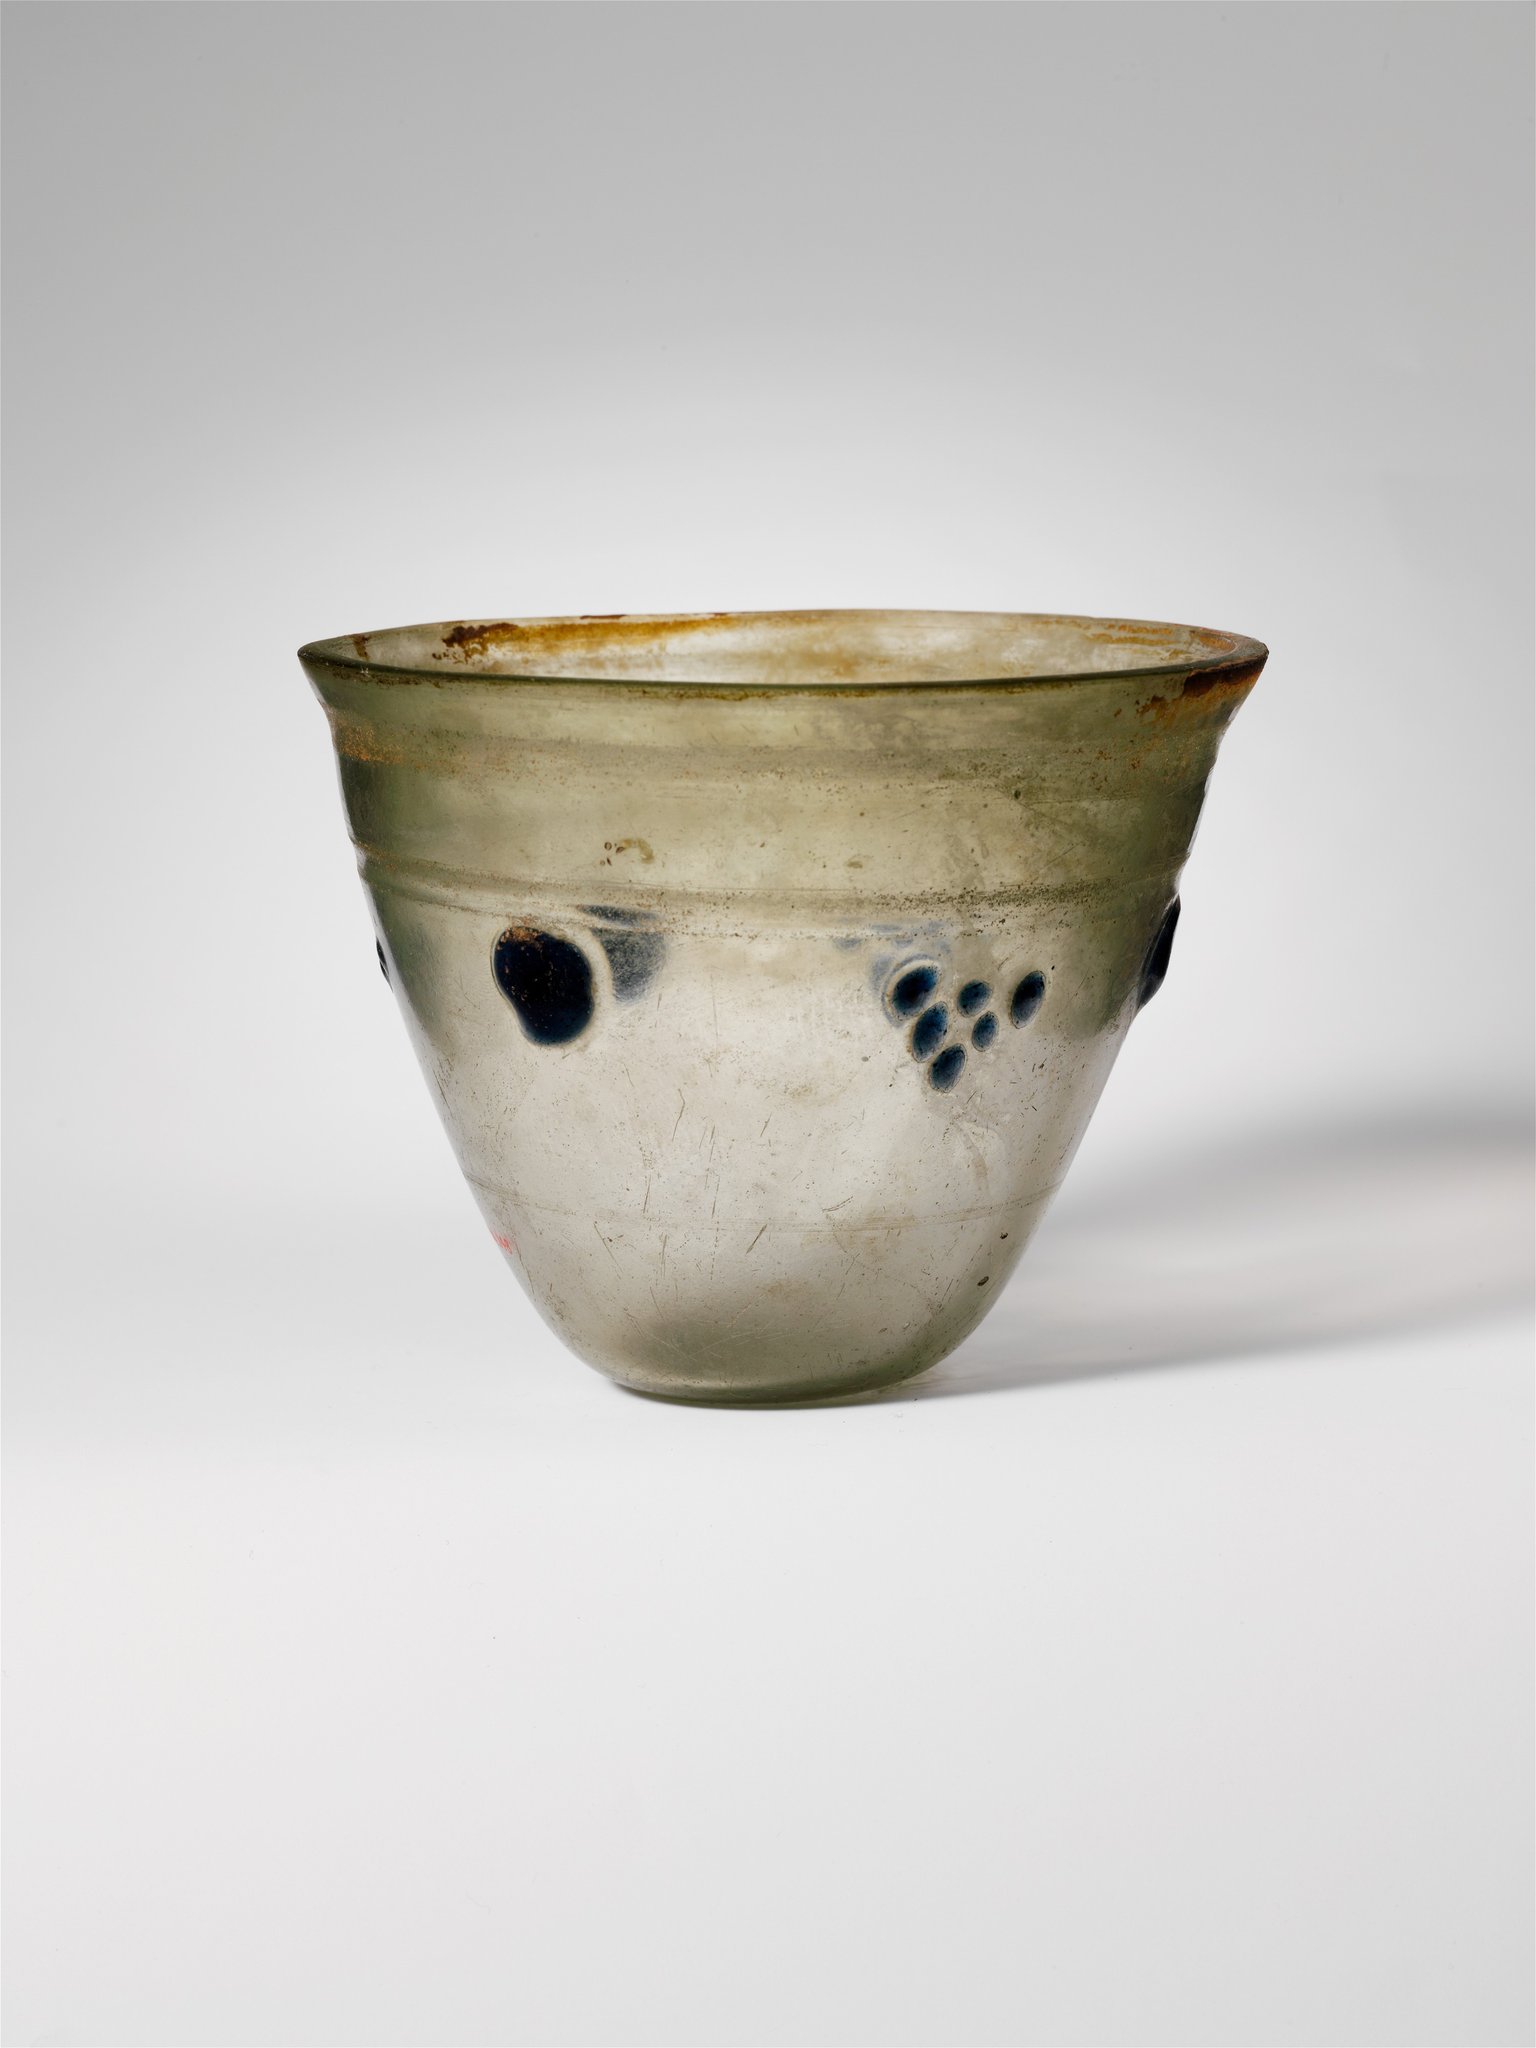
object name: beaker or lamp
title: Glass beaker or lamp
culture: roman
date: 301-400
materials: glass